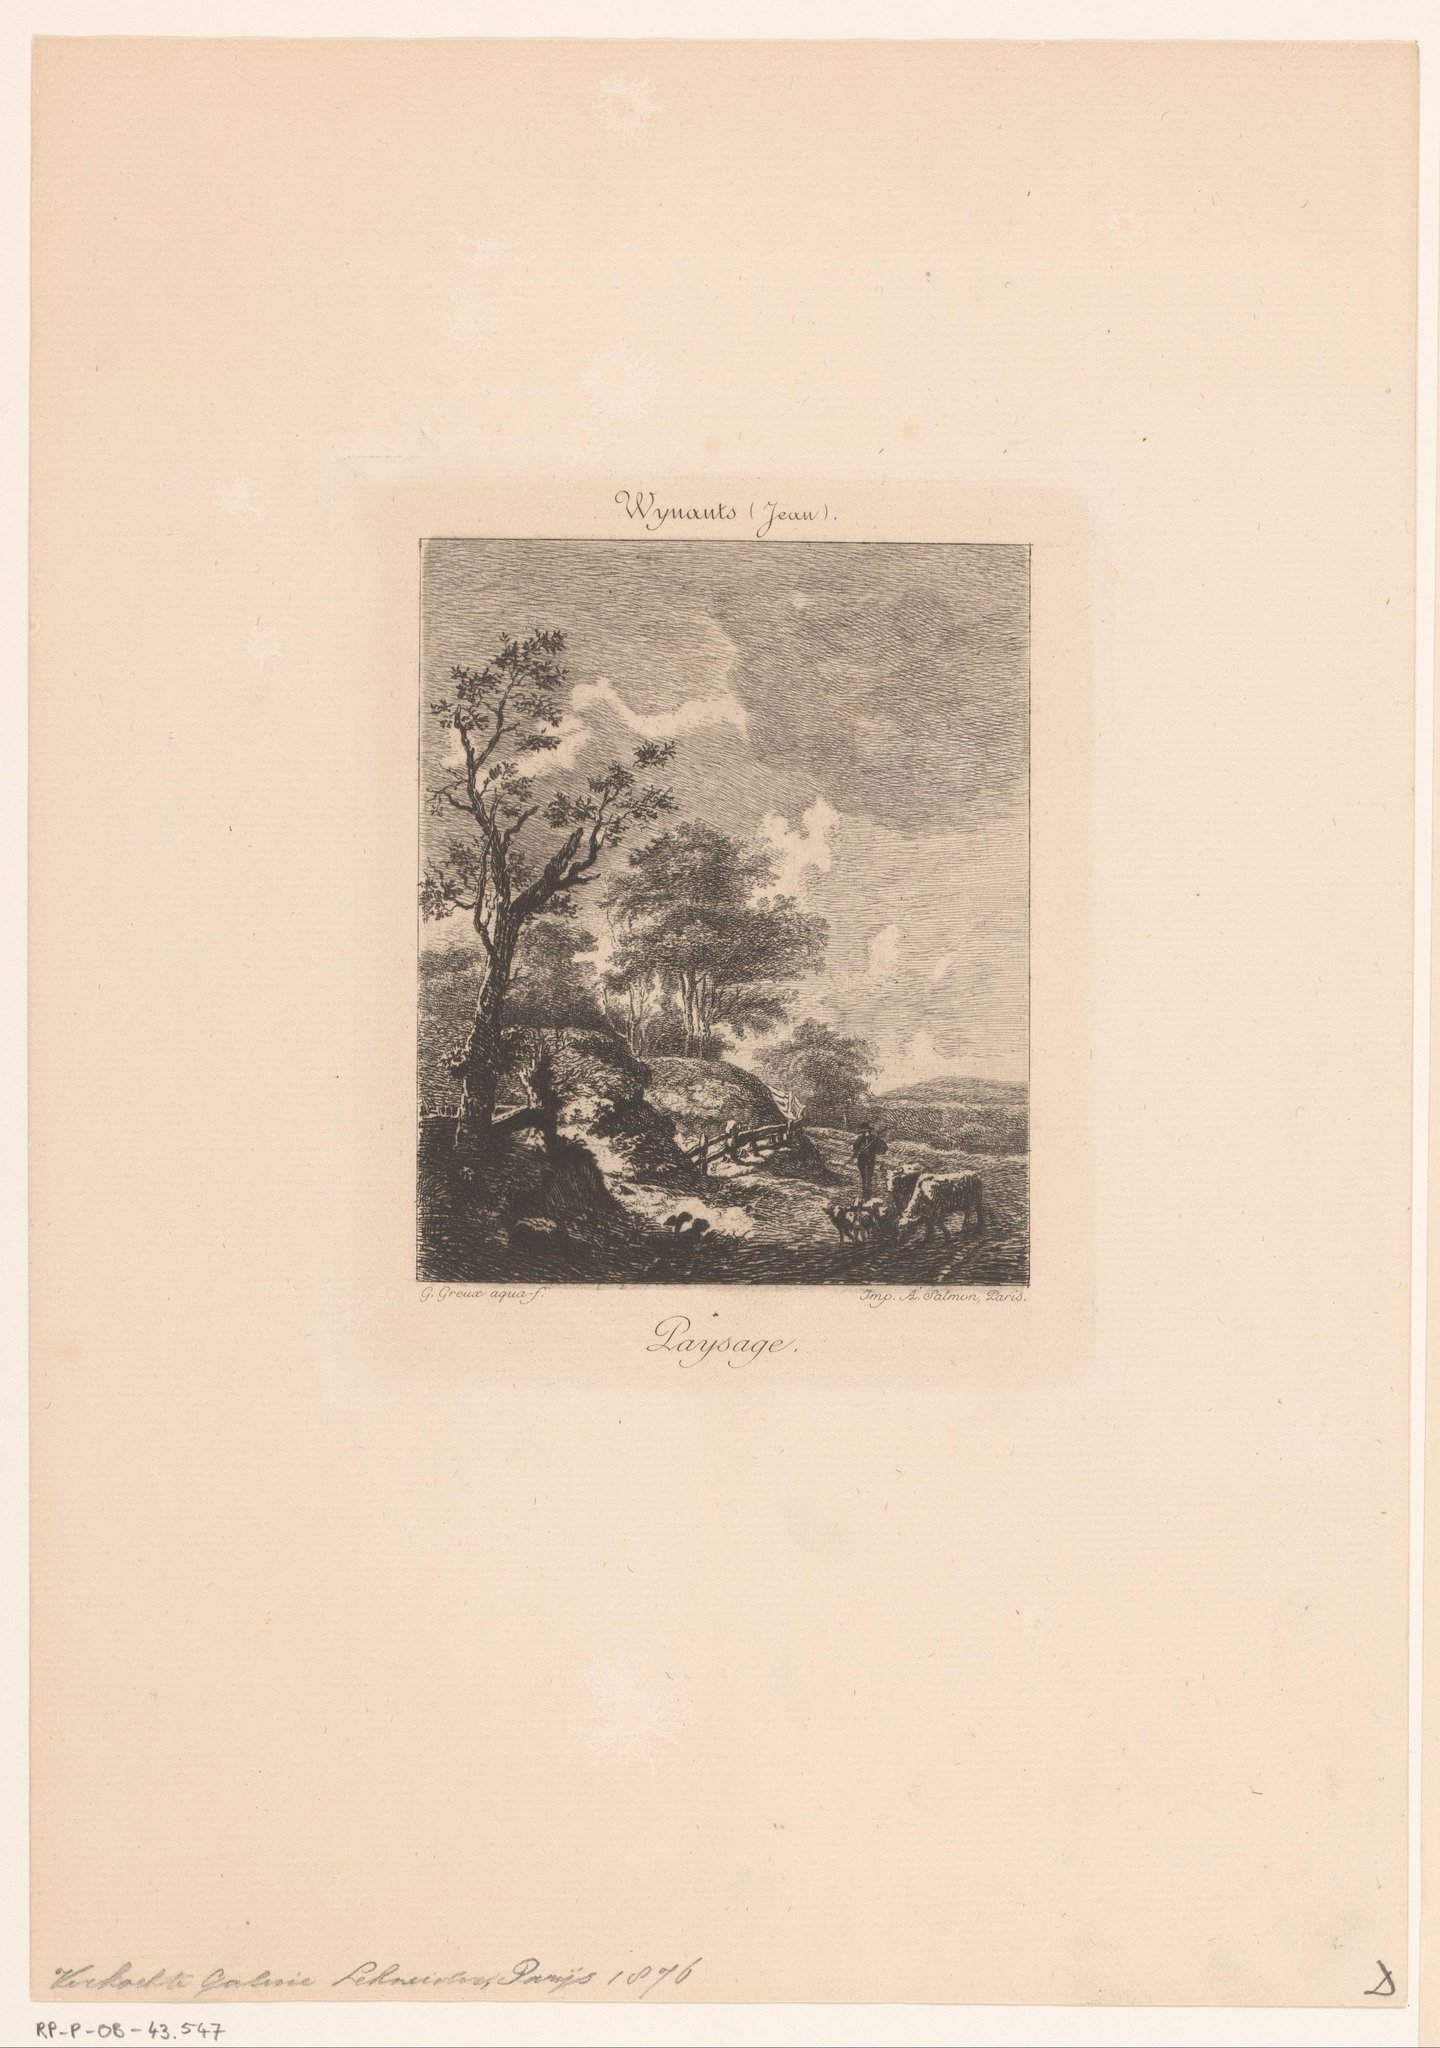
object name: print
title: Landschap met een herder en zijn kudde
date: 1880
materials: paper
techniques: etching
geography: paris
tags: landscapes, herding, herdsman, herdswoman, shepherd, shepherdess, cowherd, etc.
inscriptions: collector's mark: Lugt 2228